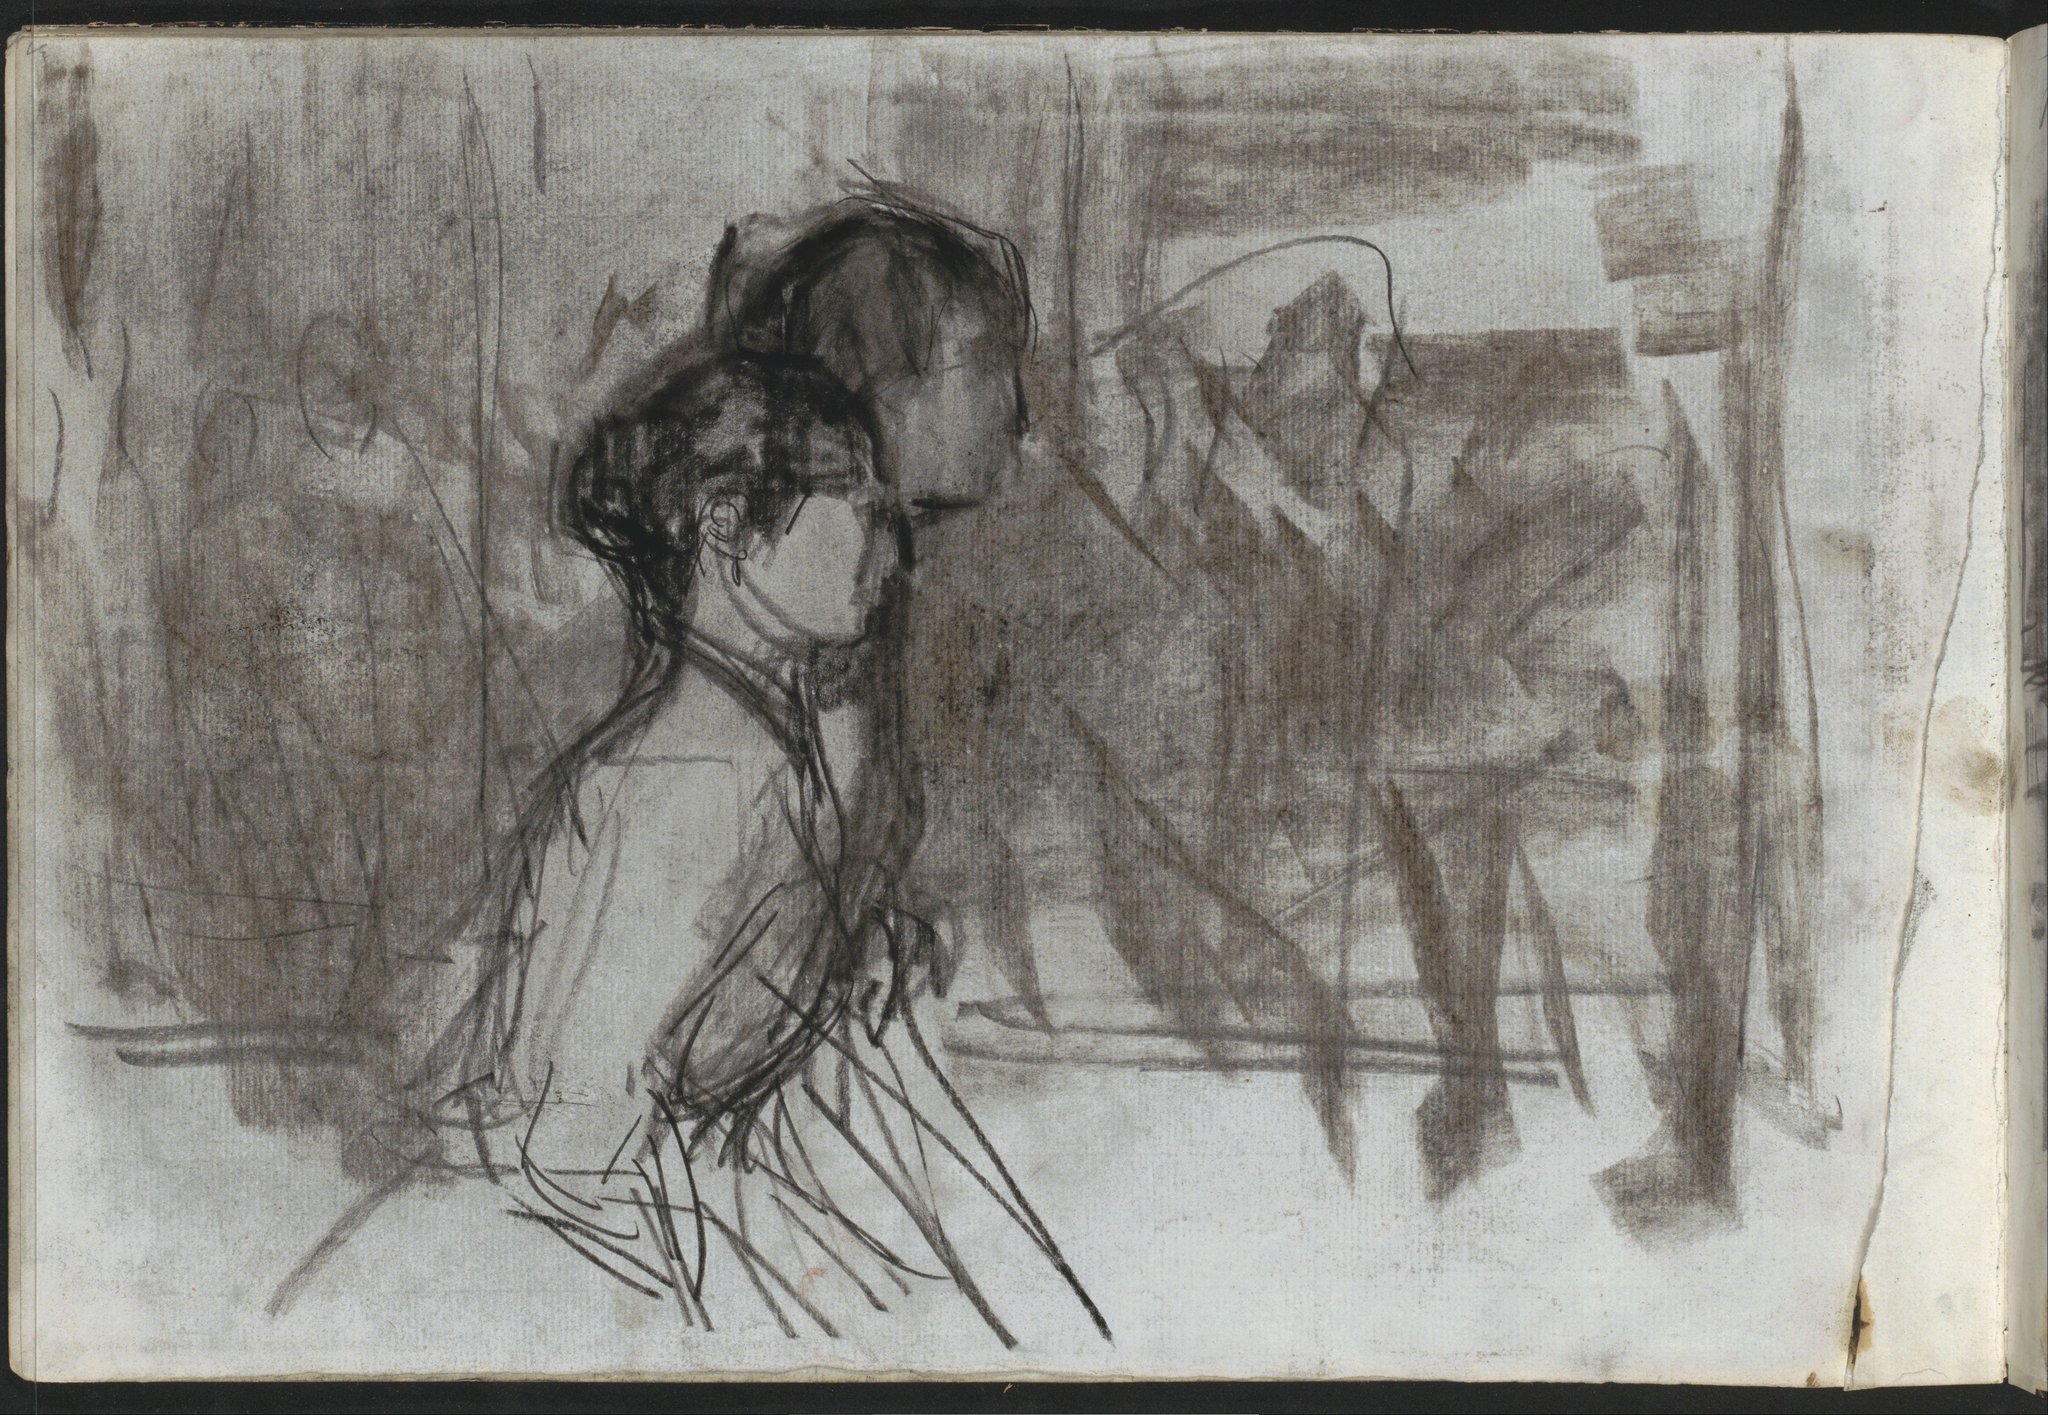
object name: sketchbook leaf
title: Twee vrouwen op straat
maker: isaac israels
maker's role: draughtsman, painter, print maker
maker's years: 1865-1934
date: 1886-1934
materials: chalk, charcoal, paper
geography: amsterdam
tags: adult woman, street (+ city(-scape) with figures, staffage)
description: Op de achtergrond nog enkele figuren. Blad 4 verso uit schetsboek LXX met 17 bladen.